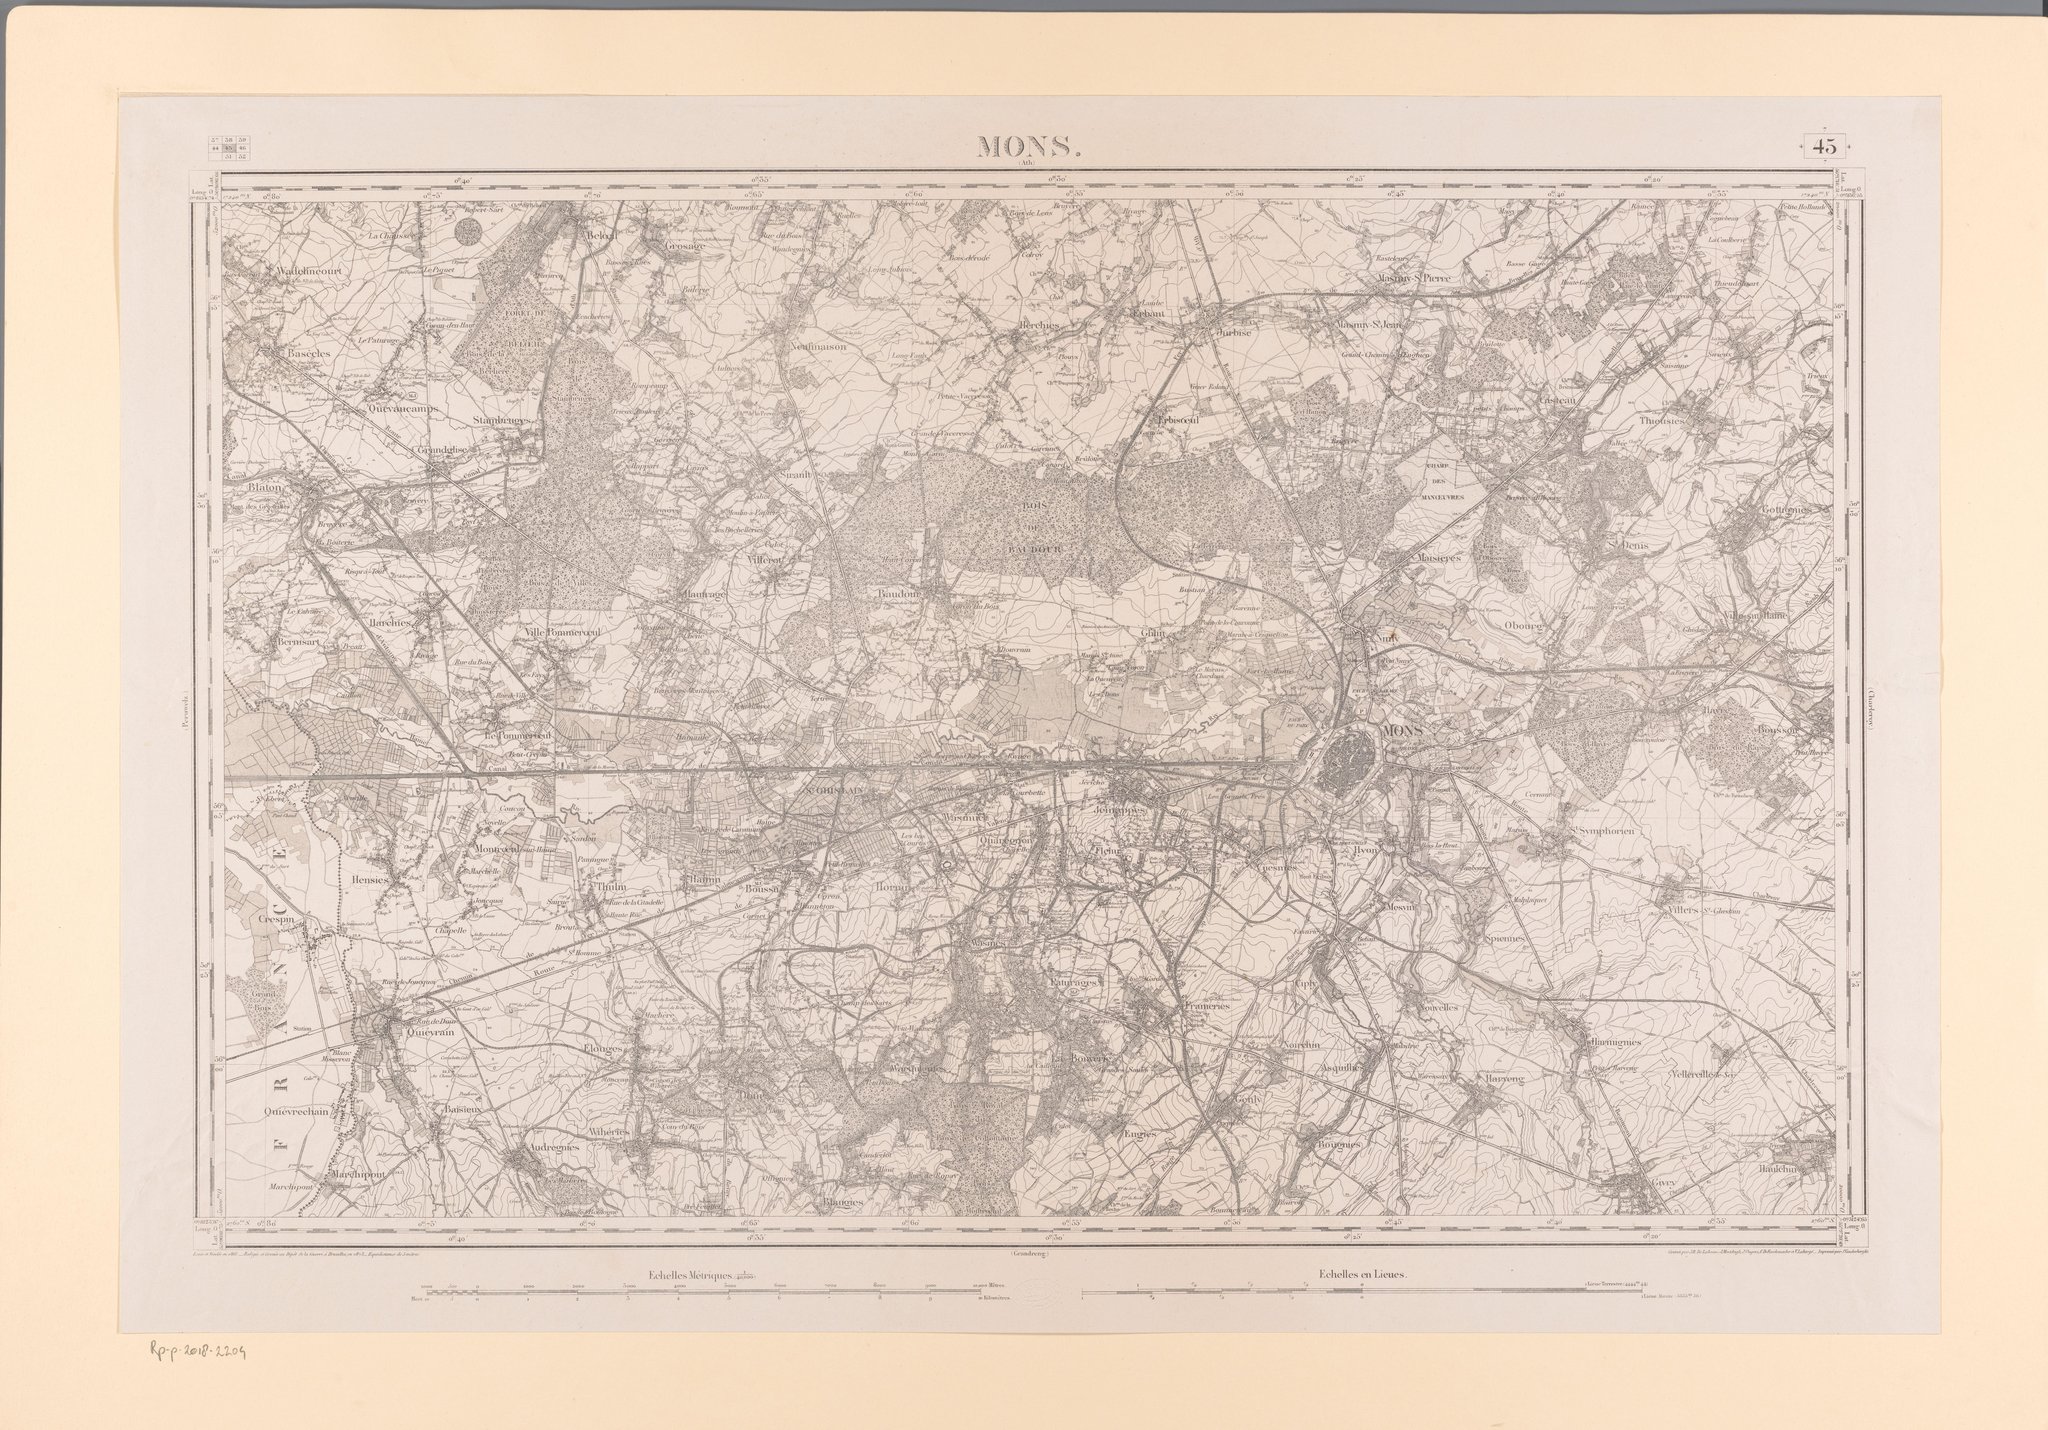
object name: print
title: Mons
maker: j. vanderborght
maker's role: printer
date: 1873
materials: paper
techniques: lithograph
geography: brussels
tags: maps of separate countries or regions, henegouwen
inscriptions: check stamp: ‘Depot de la Guerre Belgique’